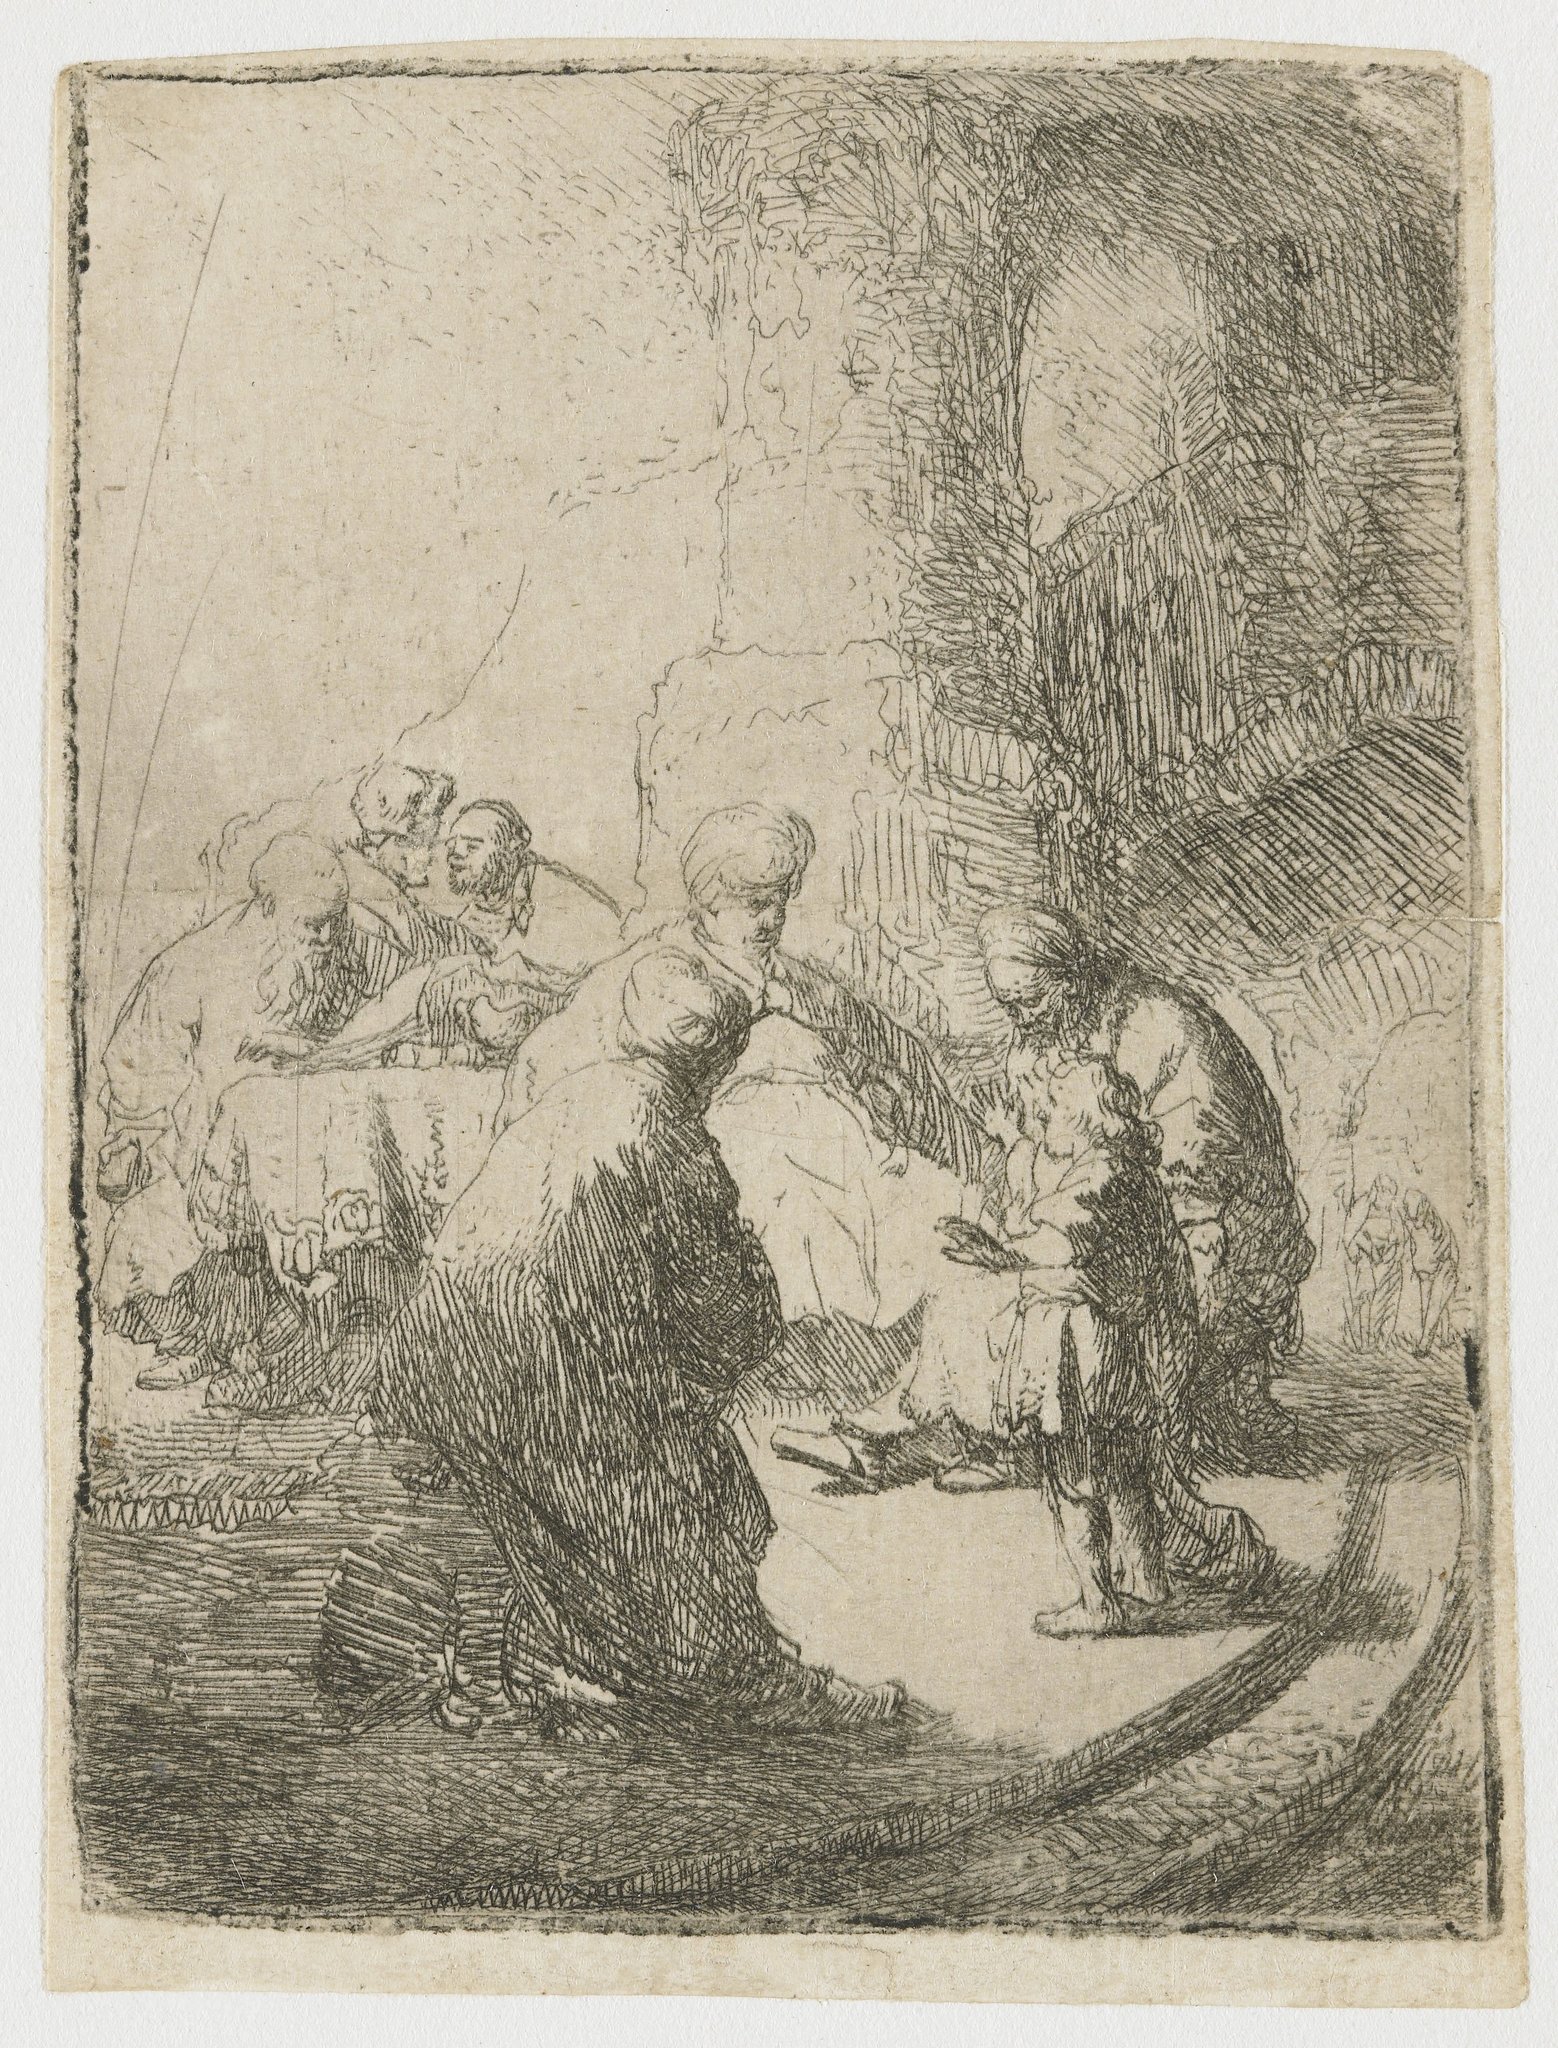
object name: print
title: Christ Disputing with the Doctors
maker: rembrandt van rijn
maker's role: draughtsman, painter, print maker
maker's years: 1606-1669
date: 1630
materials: paper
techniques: etching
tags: christ explaining his doctrine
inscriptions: collector's mark: Lugt 240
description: After celebrating Passover in Jerusalem, Joseph and Mary discover that their 12-year-old son did not travel home with them in the caravan. They turn back and after three days finally find Christ in the Temple in discussion with the doctors of the church. Bathed in light, he gestures excitedly amid the adults. His anxious parents approach from the far right.